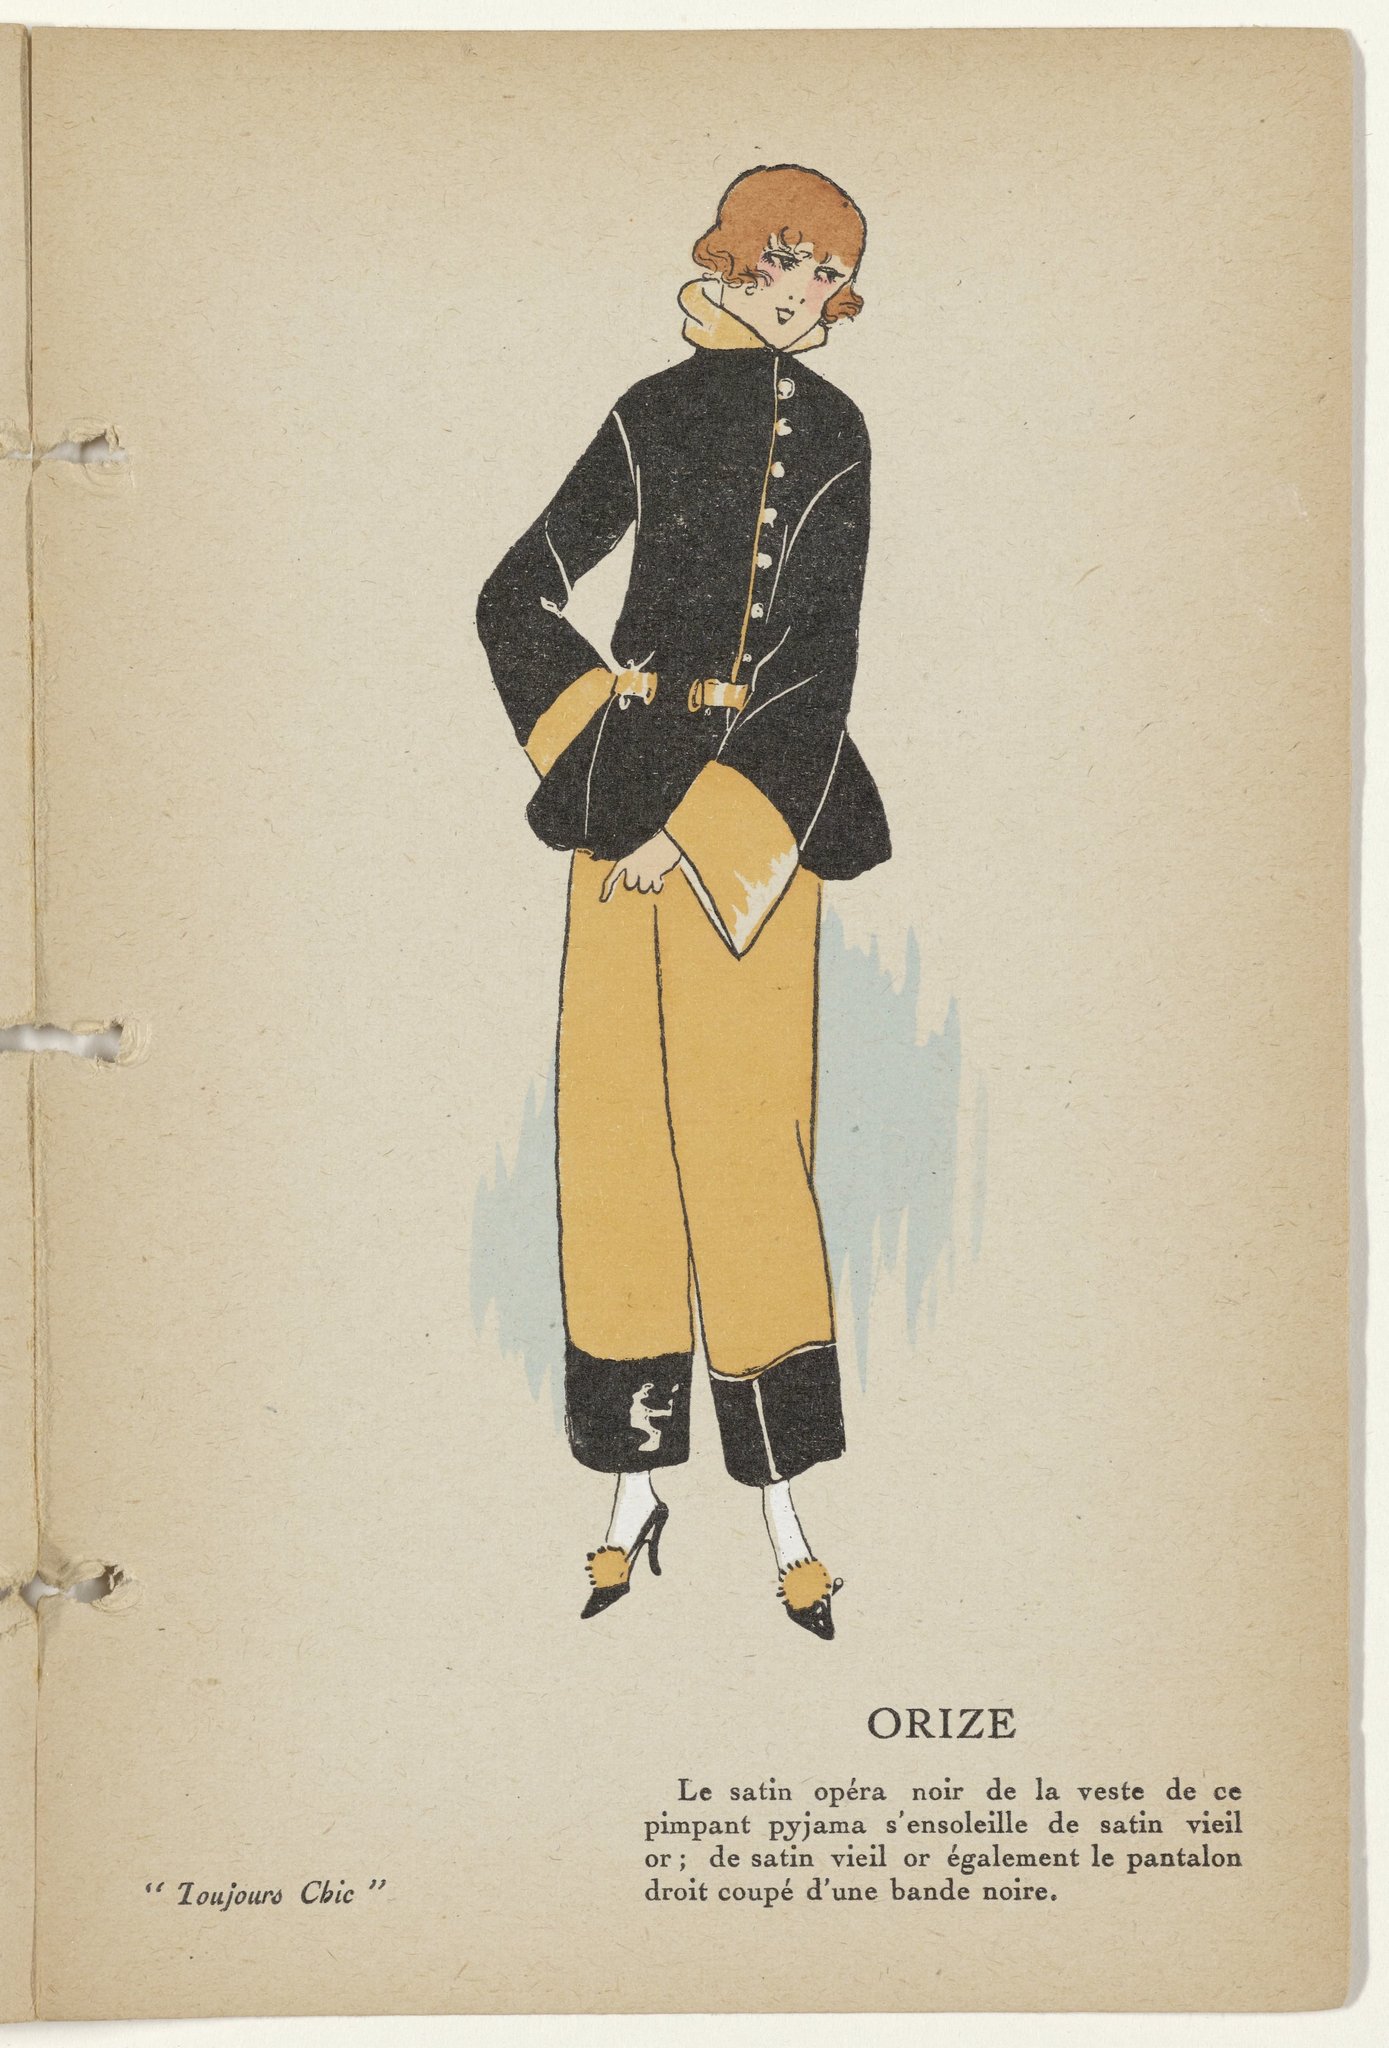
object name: fashion print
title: Toujours Chic Les Deshabillés, Hiver 1921-1922: Orize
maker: g-p. joumard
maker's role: publisher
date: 1921-1922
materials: paper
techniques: letterpress printing, pochoir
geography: paris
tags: fashion plates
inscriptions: date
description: Prent uit Catalogus "Toujours Chic" waarin een overzicht van de wintermode 1921-1922.